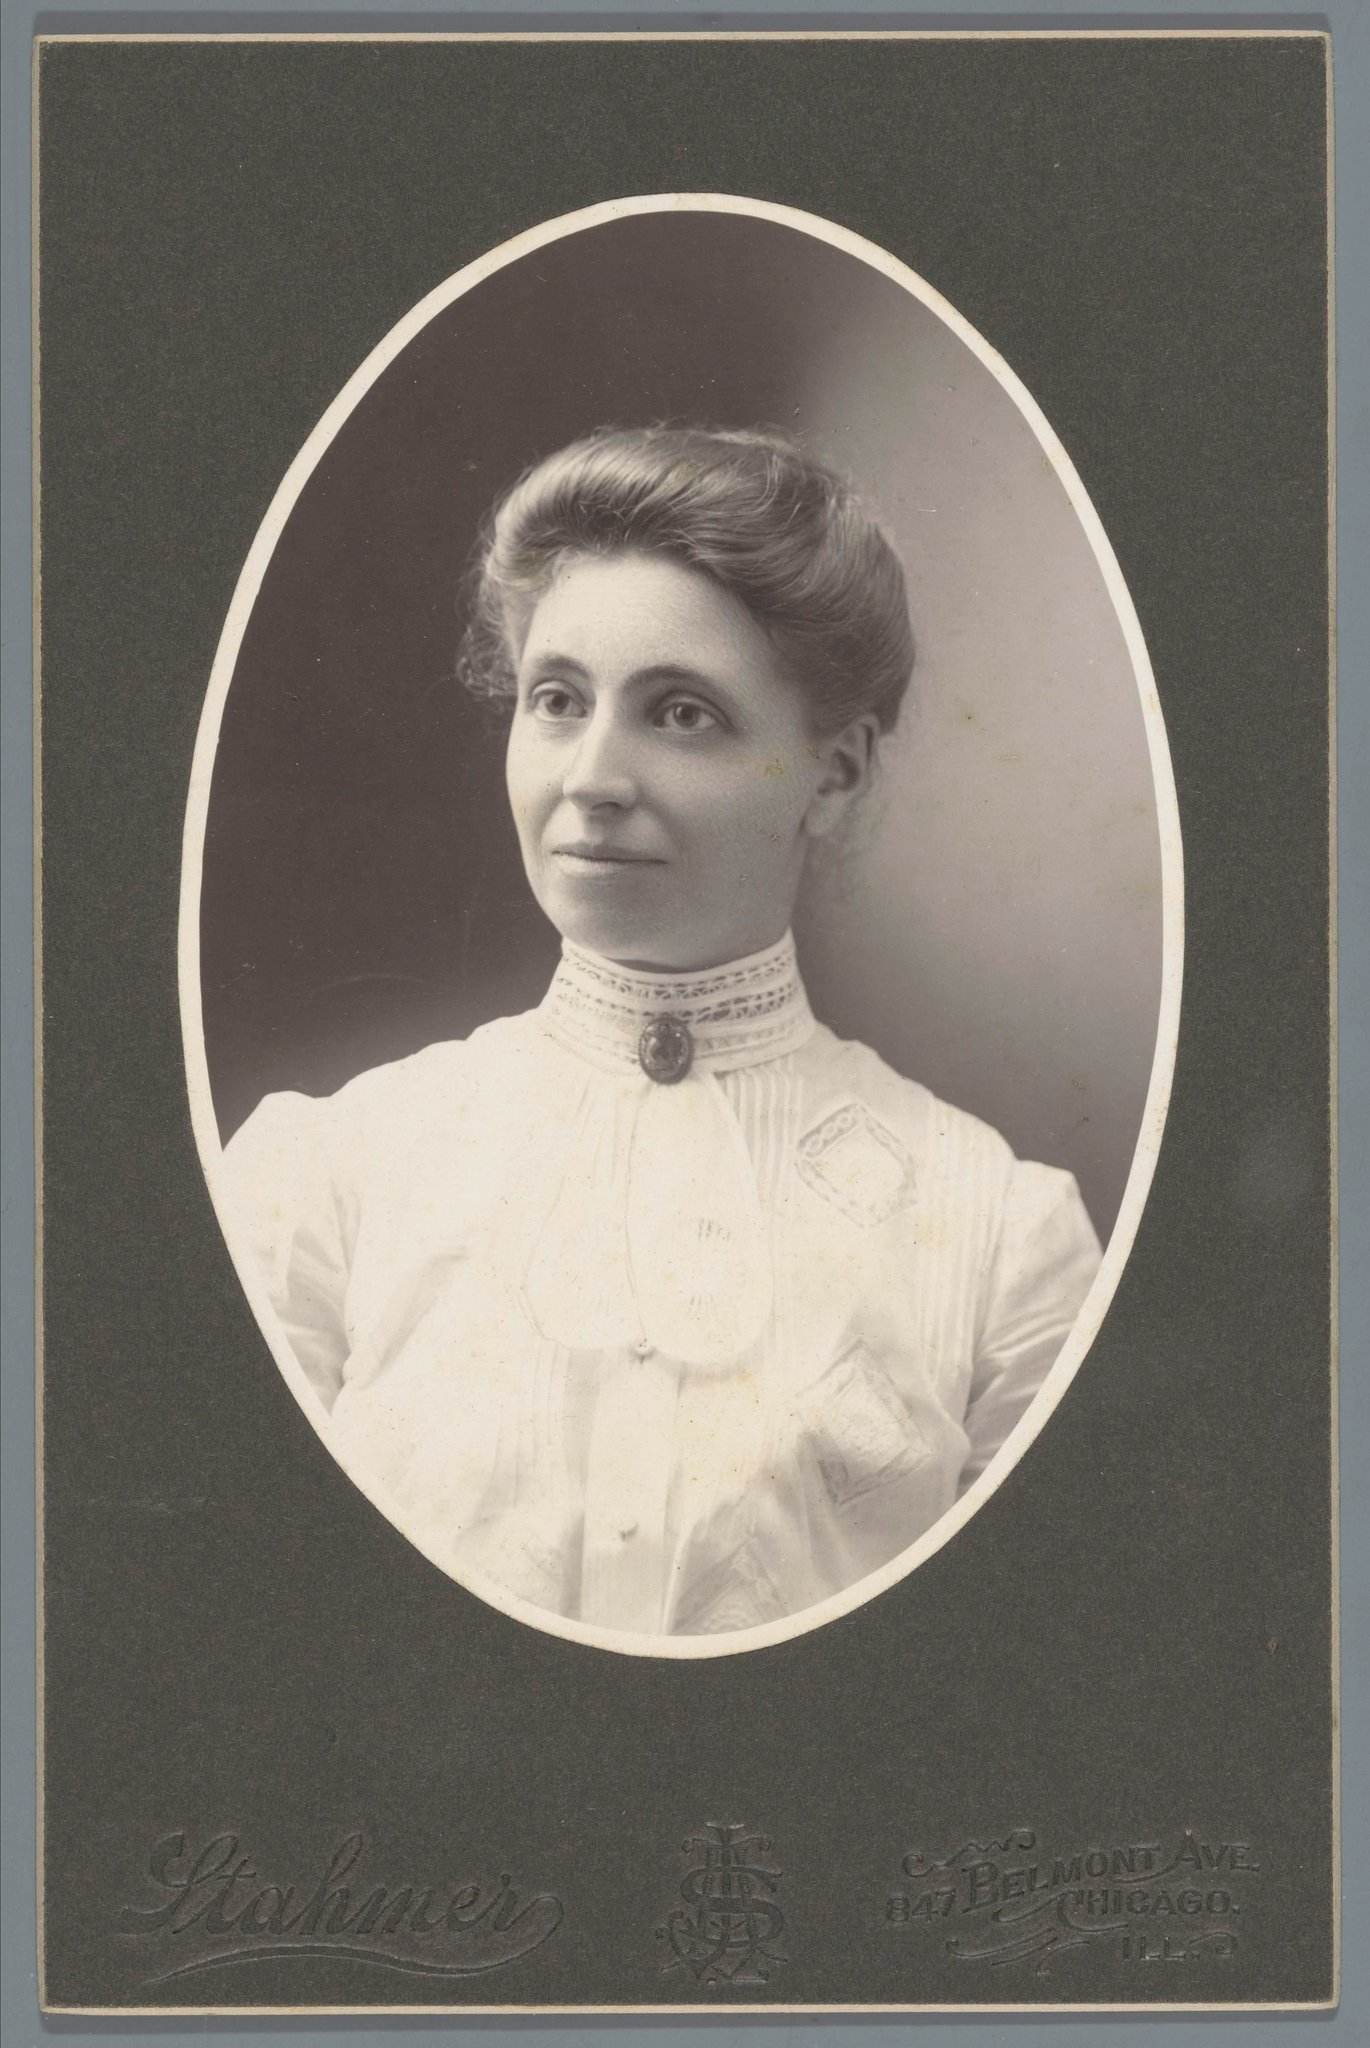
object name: cabinet photograph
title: Portret van een onbekende vrouw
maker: stahmer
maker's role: fotograaf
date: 1890-1910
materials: cardboard, photographic support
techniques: gelatin silver print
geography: chicago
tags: adult woman